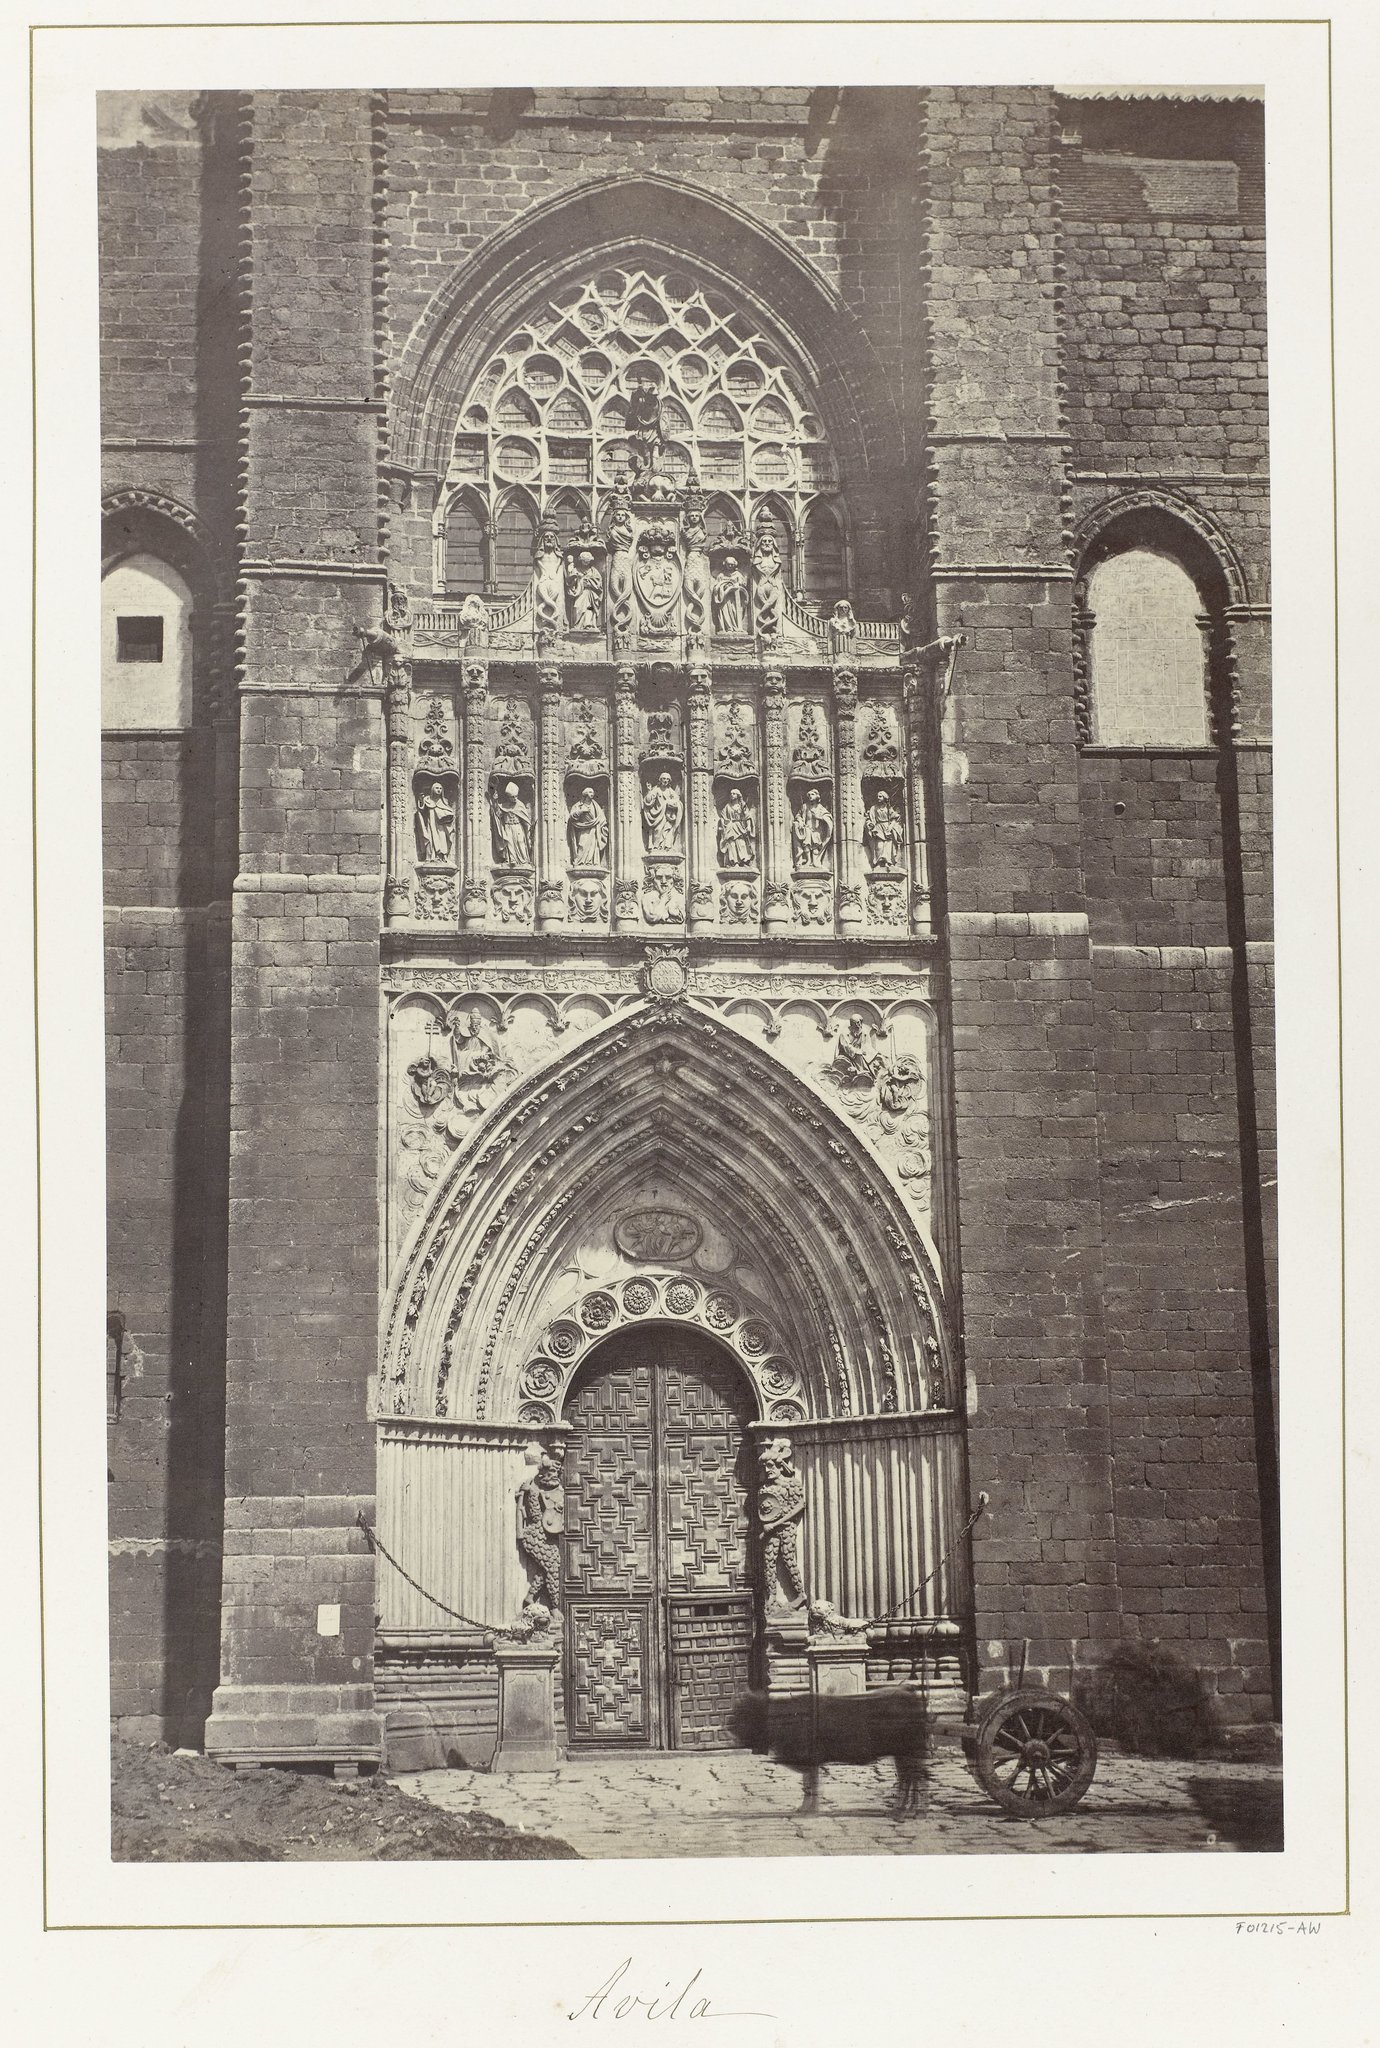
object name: photograph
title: Portaal van de kathedraal van Avila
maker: charles clifford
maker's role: fotograaf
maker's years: 1819-1863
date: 1850-1863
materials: photographic support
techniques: albumen print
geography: avila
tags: parts of church exterior and annexes: portal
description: Onderdeel van Reisalbum met opnames van kunstwerken, personen en bezienswaardigheden in Spanje.